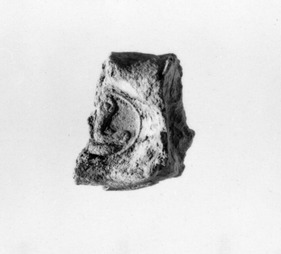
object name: sealing, cobra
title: Document Sealing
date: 1390-1352 BCE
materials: mud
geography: egypt